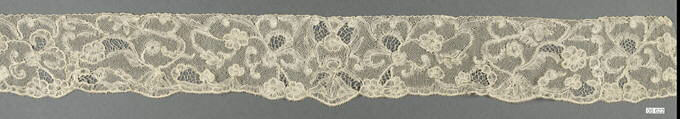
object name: strip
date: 1701-1800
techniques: lace